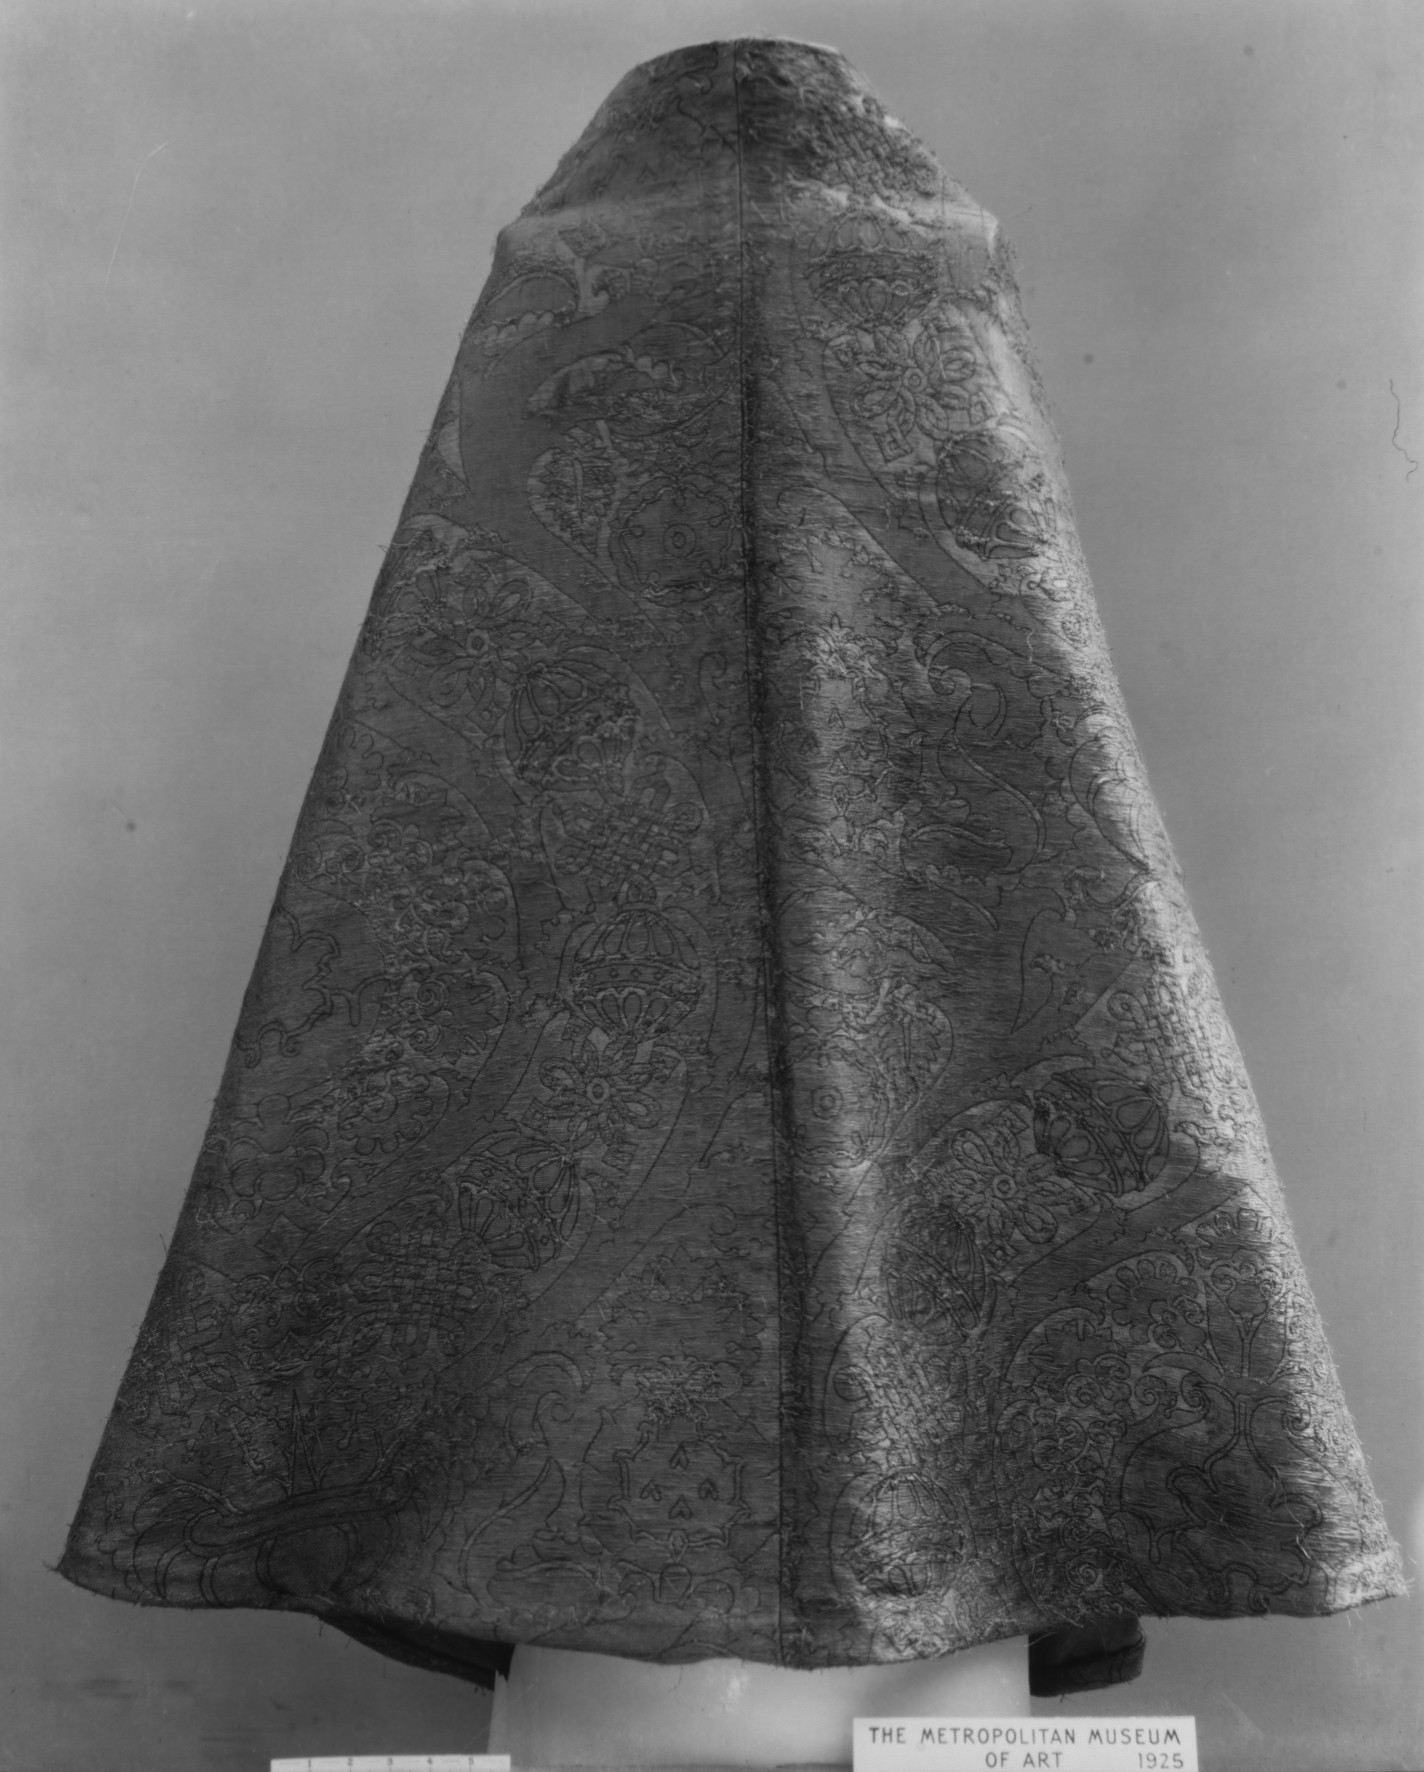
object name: cope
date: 1500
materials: metal thread, silk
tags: flowers